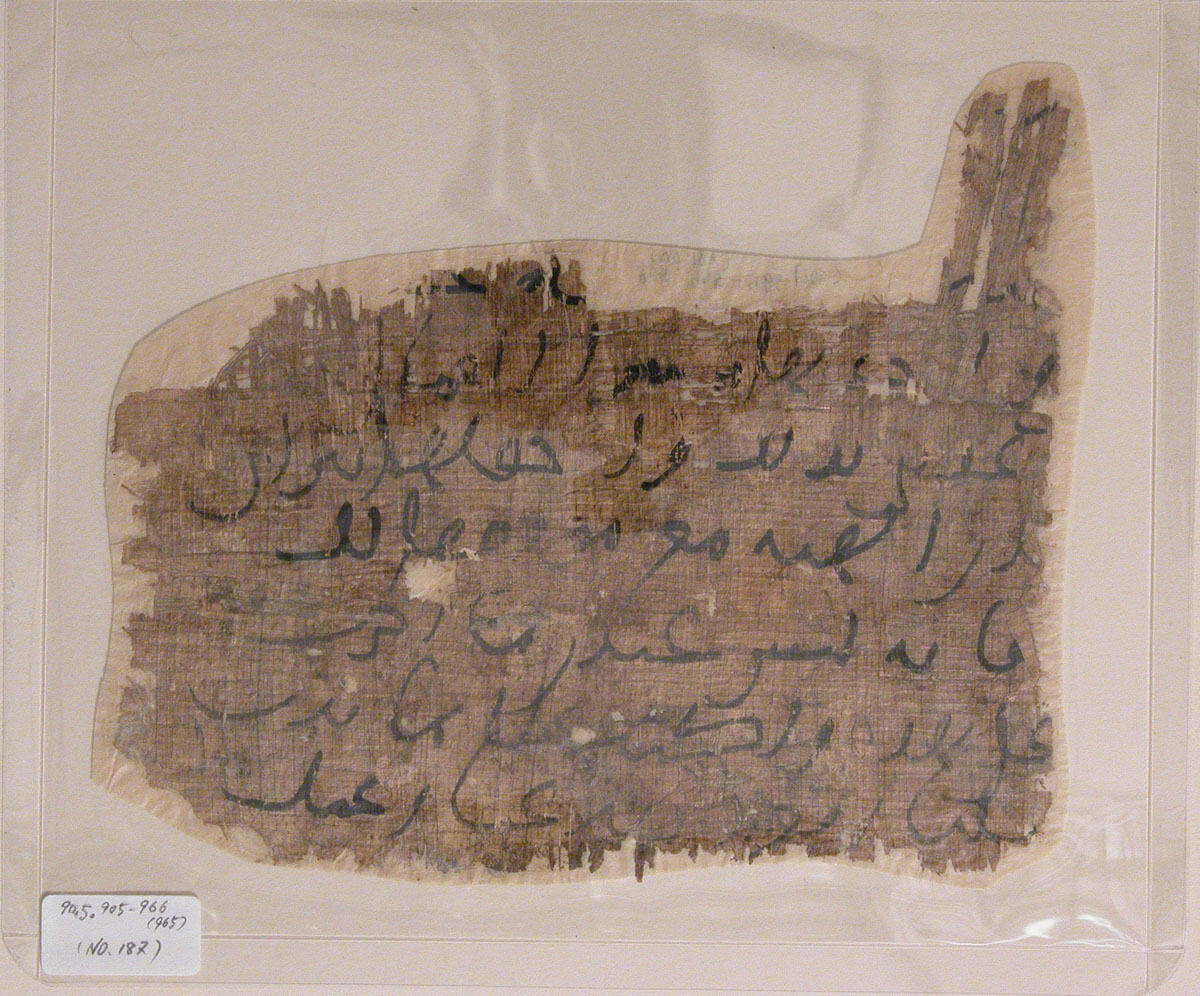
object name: non illustrated single work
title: Letter Fragment on Papyrus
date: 701-1000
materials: ink, papyrus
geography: egypt